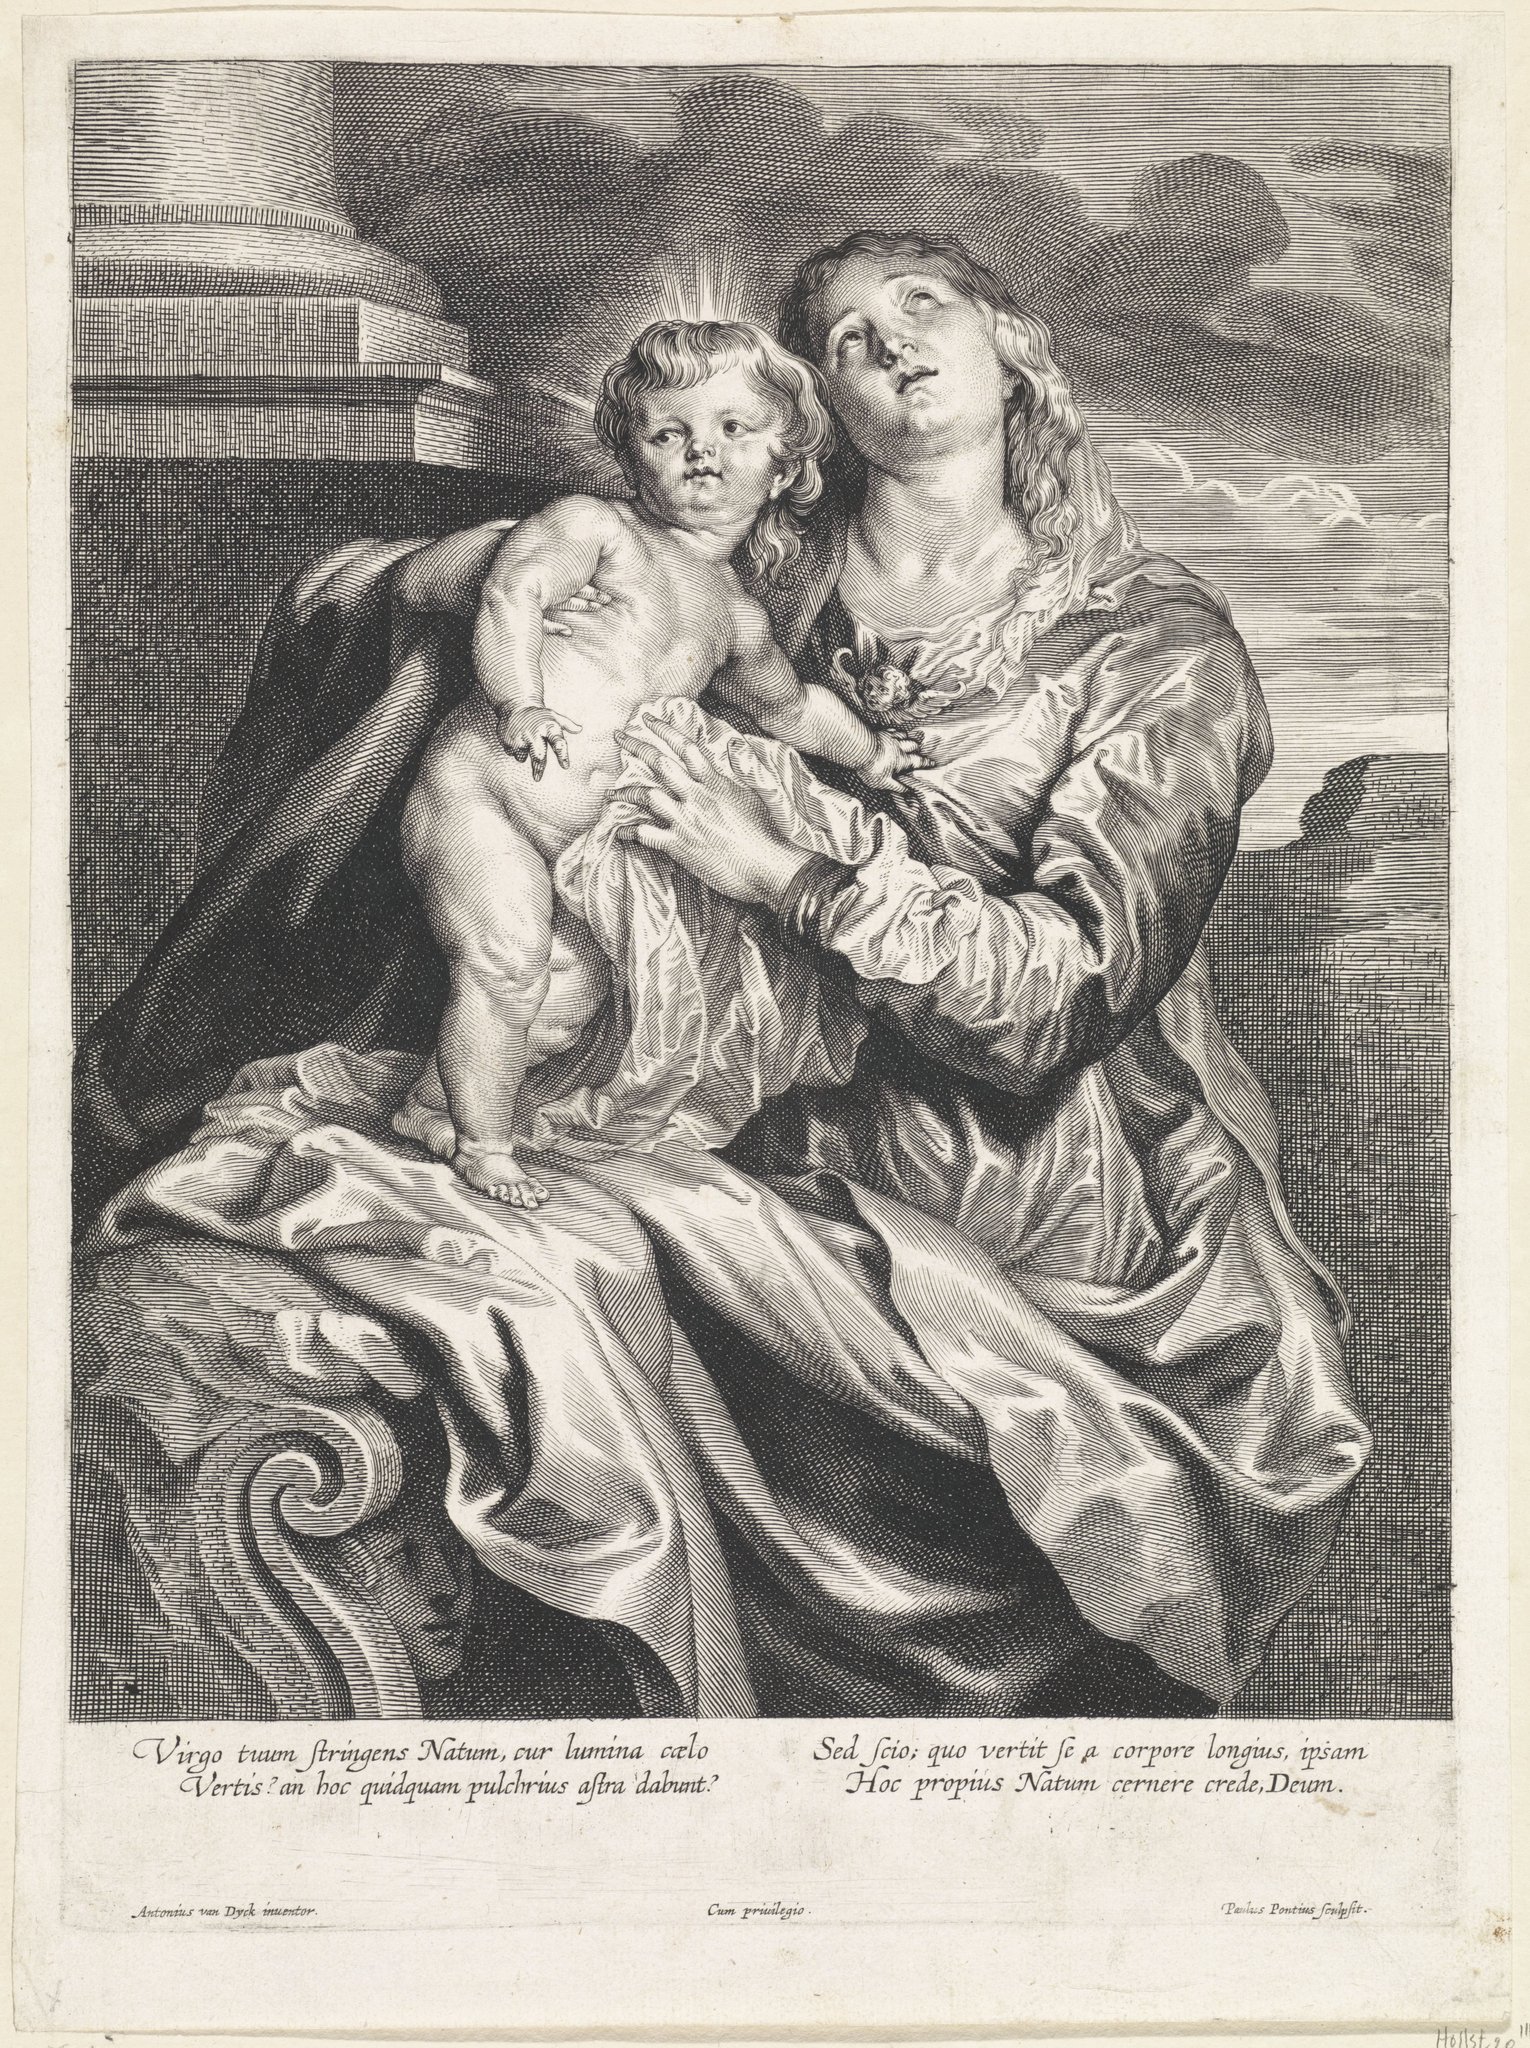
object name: print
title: Maria met het Christuskind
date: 1616-1657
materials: paper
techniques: engraving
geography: antwerp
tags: mary sitting or enthroned, the christ-child standing on her knee (christ-child to mary's left) - ff - the christ-child to mary's right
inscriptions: collector's mark: Lugt 240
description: Maria kijkt op naar de hemel. Het Christuskind staat op haar schoot. In de marge een vierregelig onderschrift, in twee kolommen, in het Latijn.